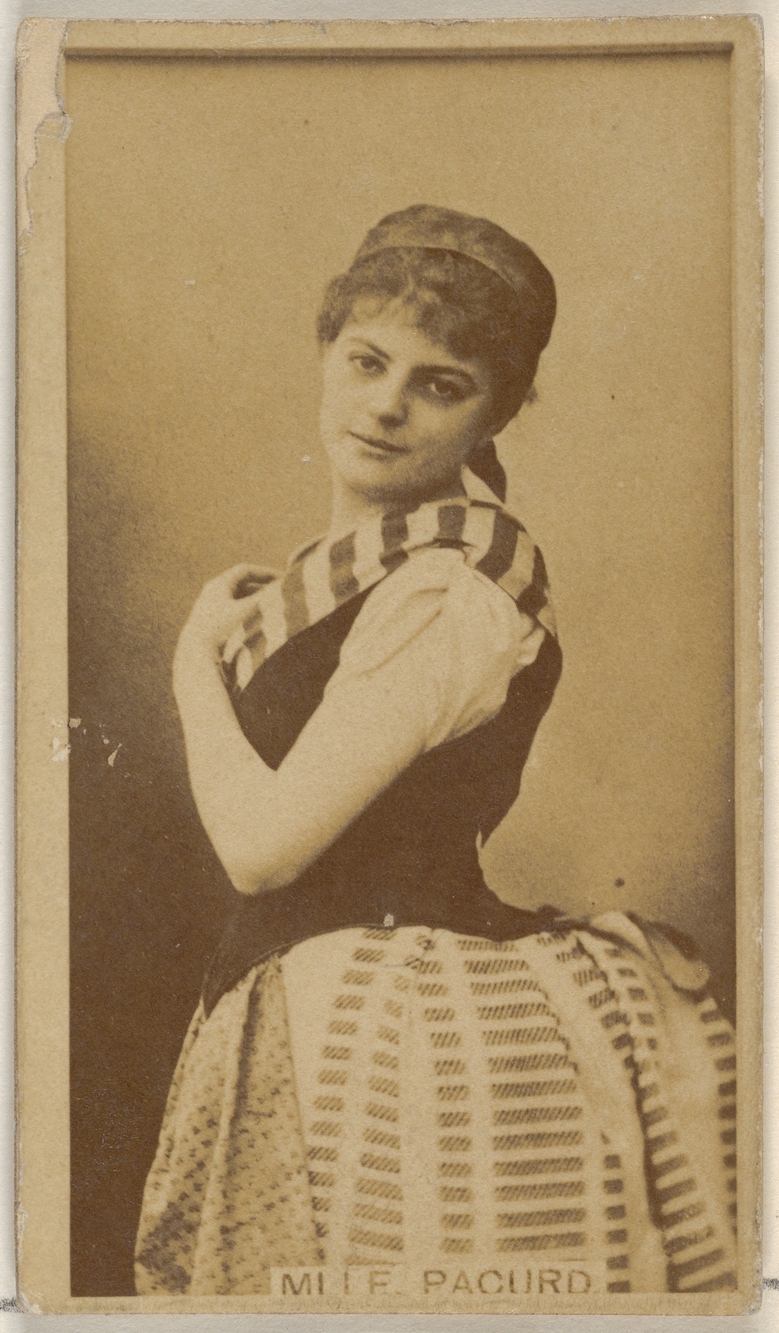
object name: photograph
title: Mlle. Pacurd, from the Actors and Actresses series (N45, Type 8) for Virginia Brights Cigarettes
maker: allen & ginter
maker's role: publisher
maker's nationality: american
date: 1888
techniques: albumen silver print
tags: portraits,women,actresses